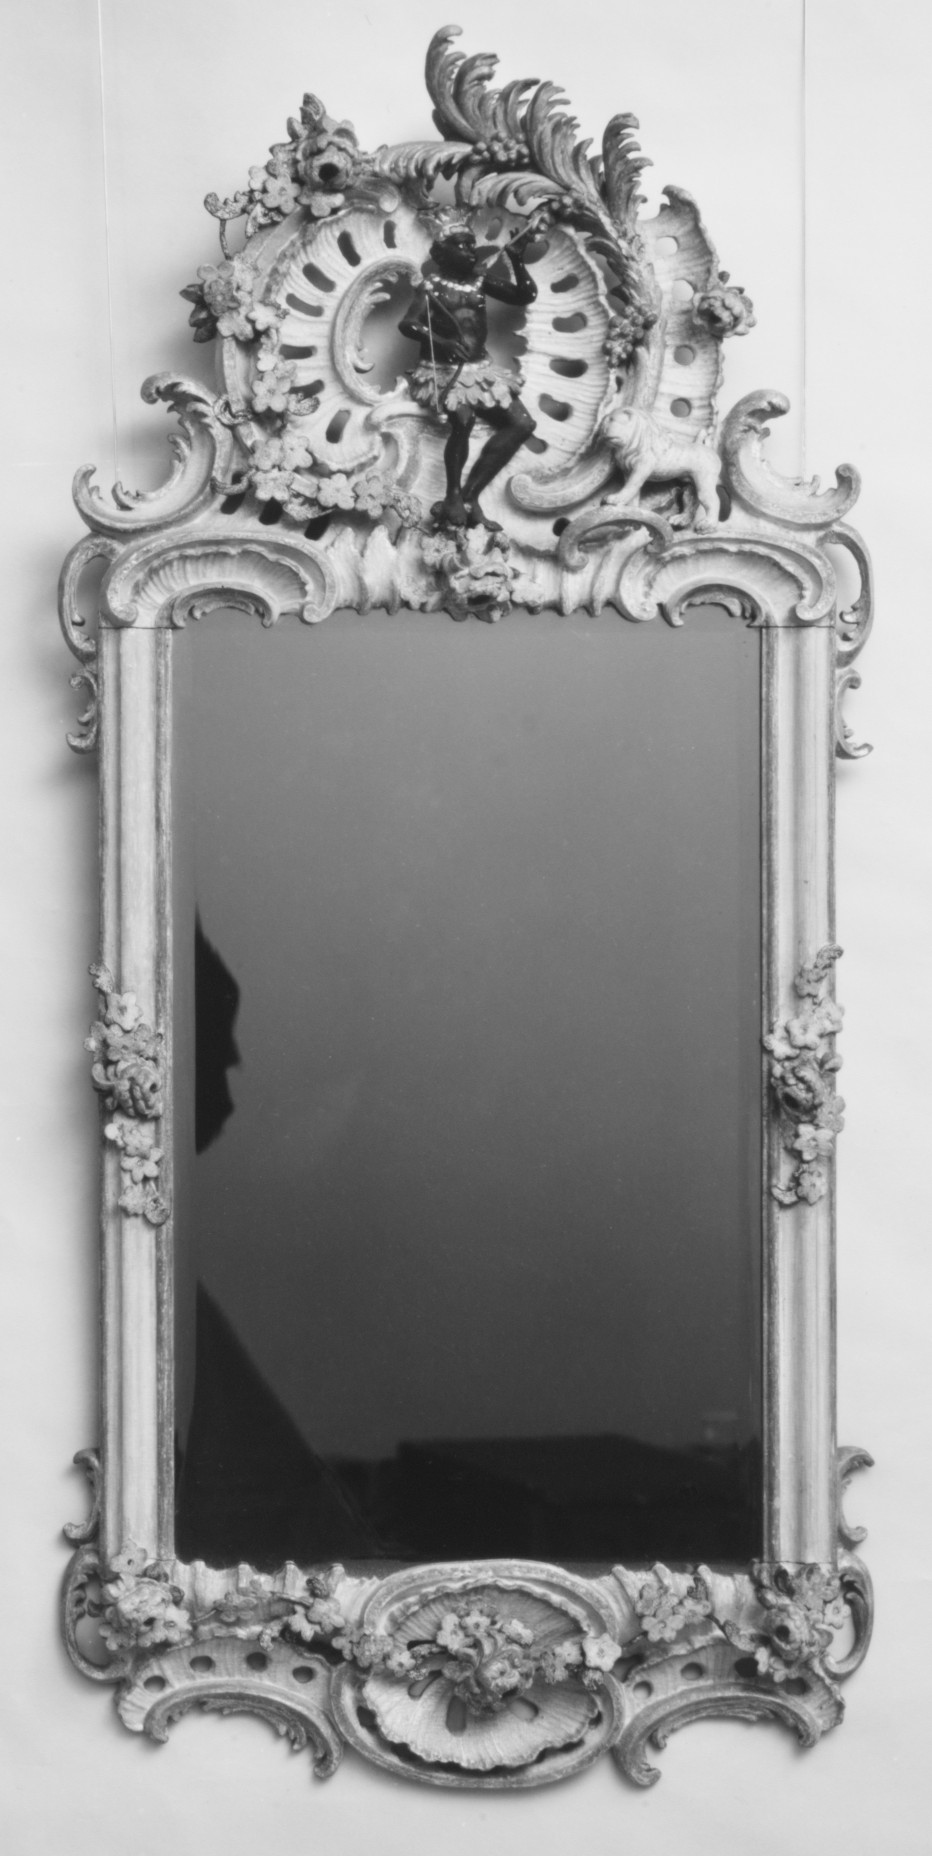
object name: mirror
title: Mirror (one of a pair)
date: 1734-1766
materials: wood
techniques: carving, gilding, painting